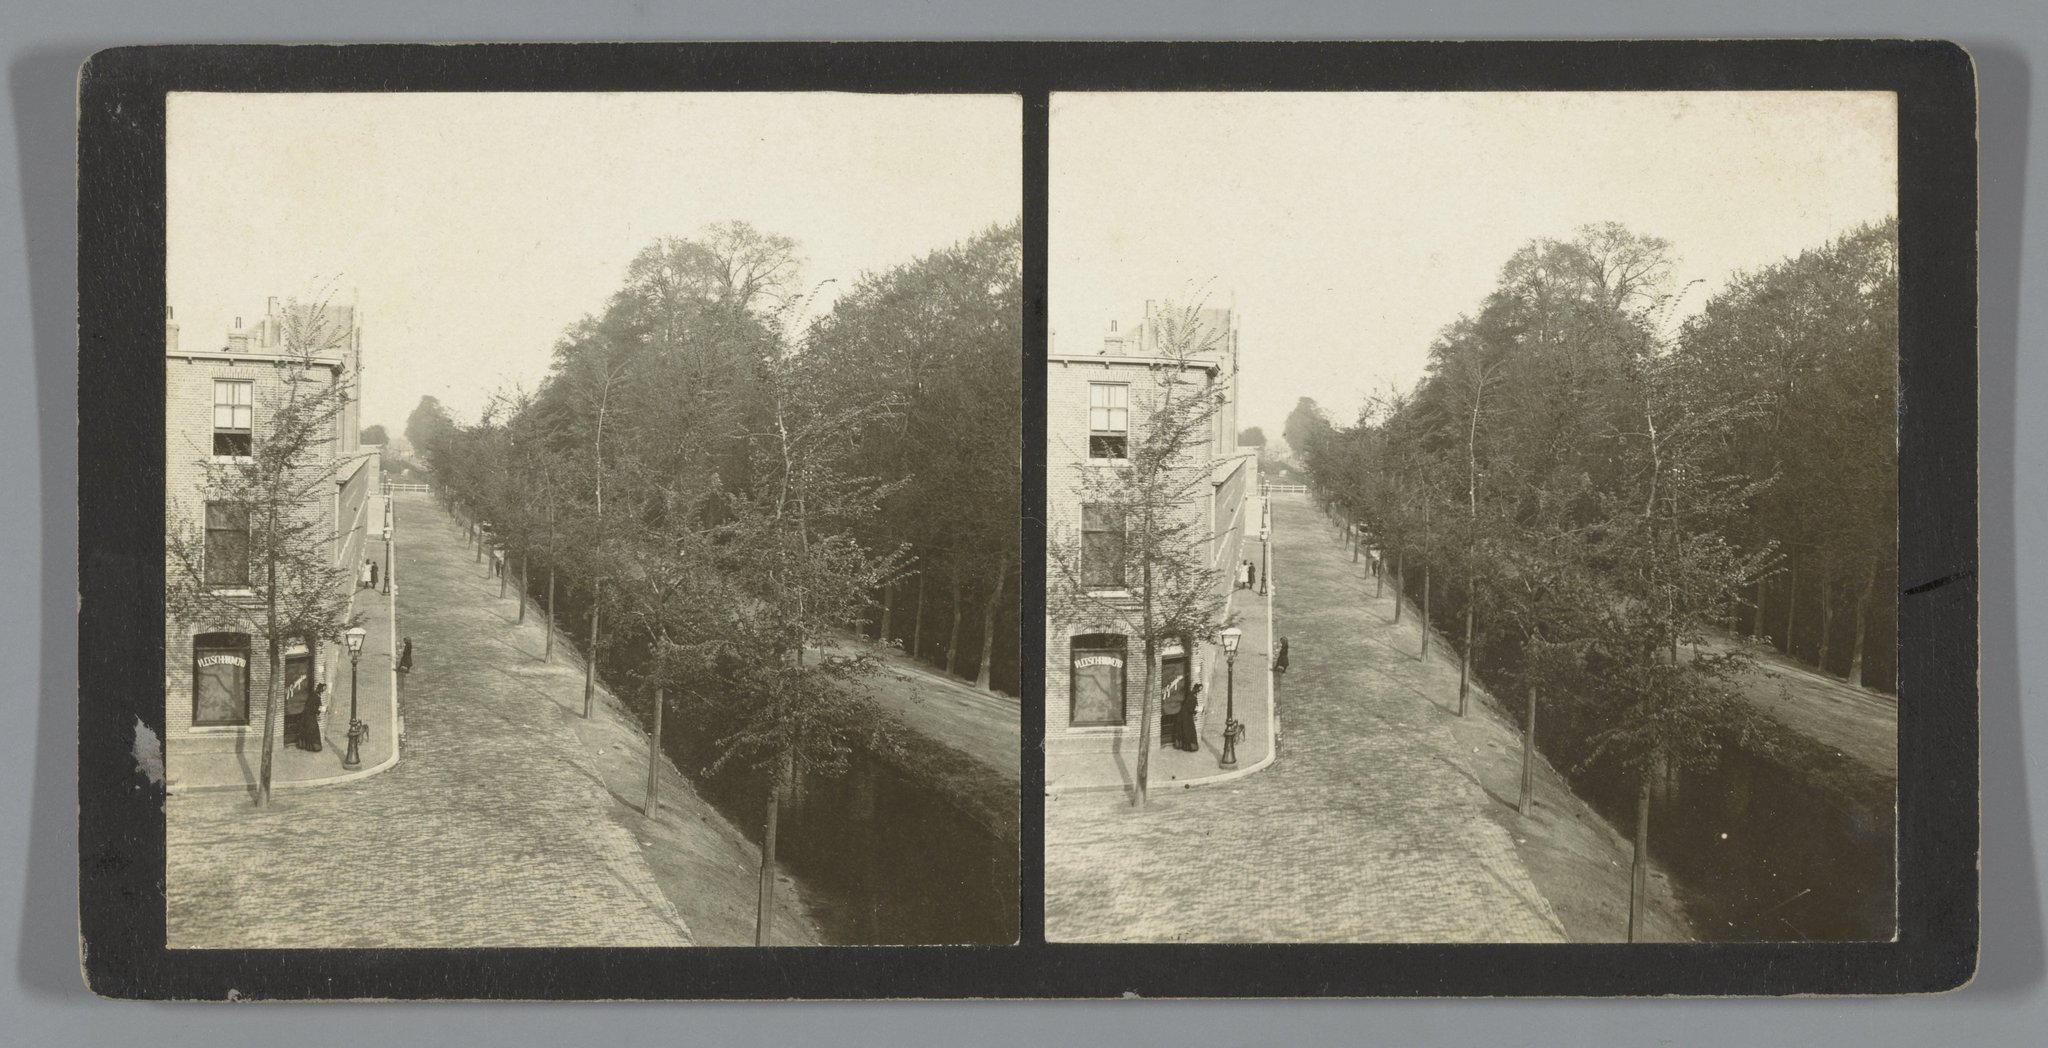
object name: stereograph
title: Gezicht op de Vleutenseweg vanuit de tekenkamer van machinefabriek Jaffa, Utrecht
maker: Anonymous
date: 1917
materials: paper, cardboard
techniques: gelatin silver print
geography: utrecht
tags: street, utrecht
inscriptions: number: ‘No 397’